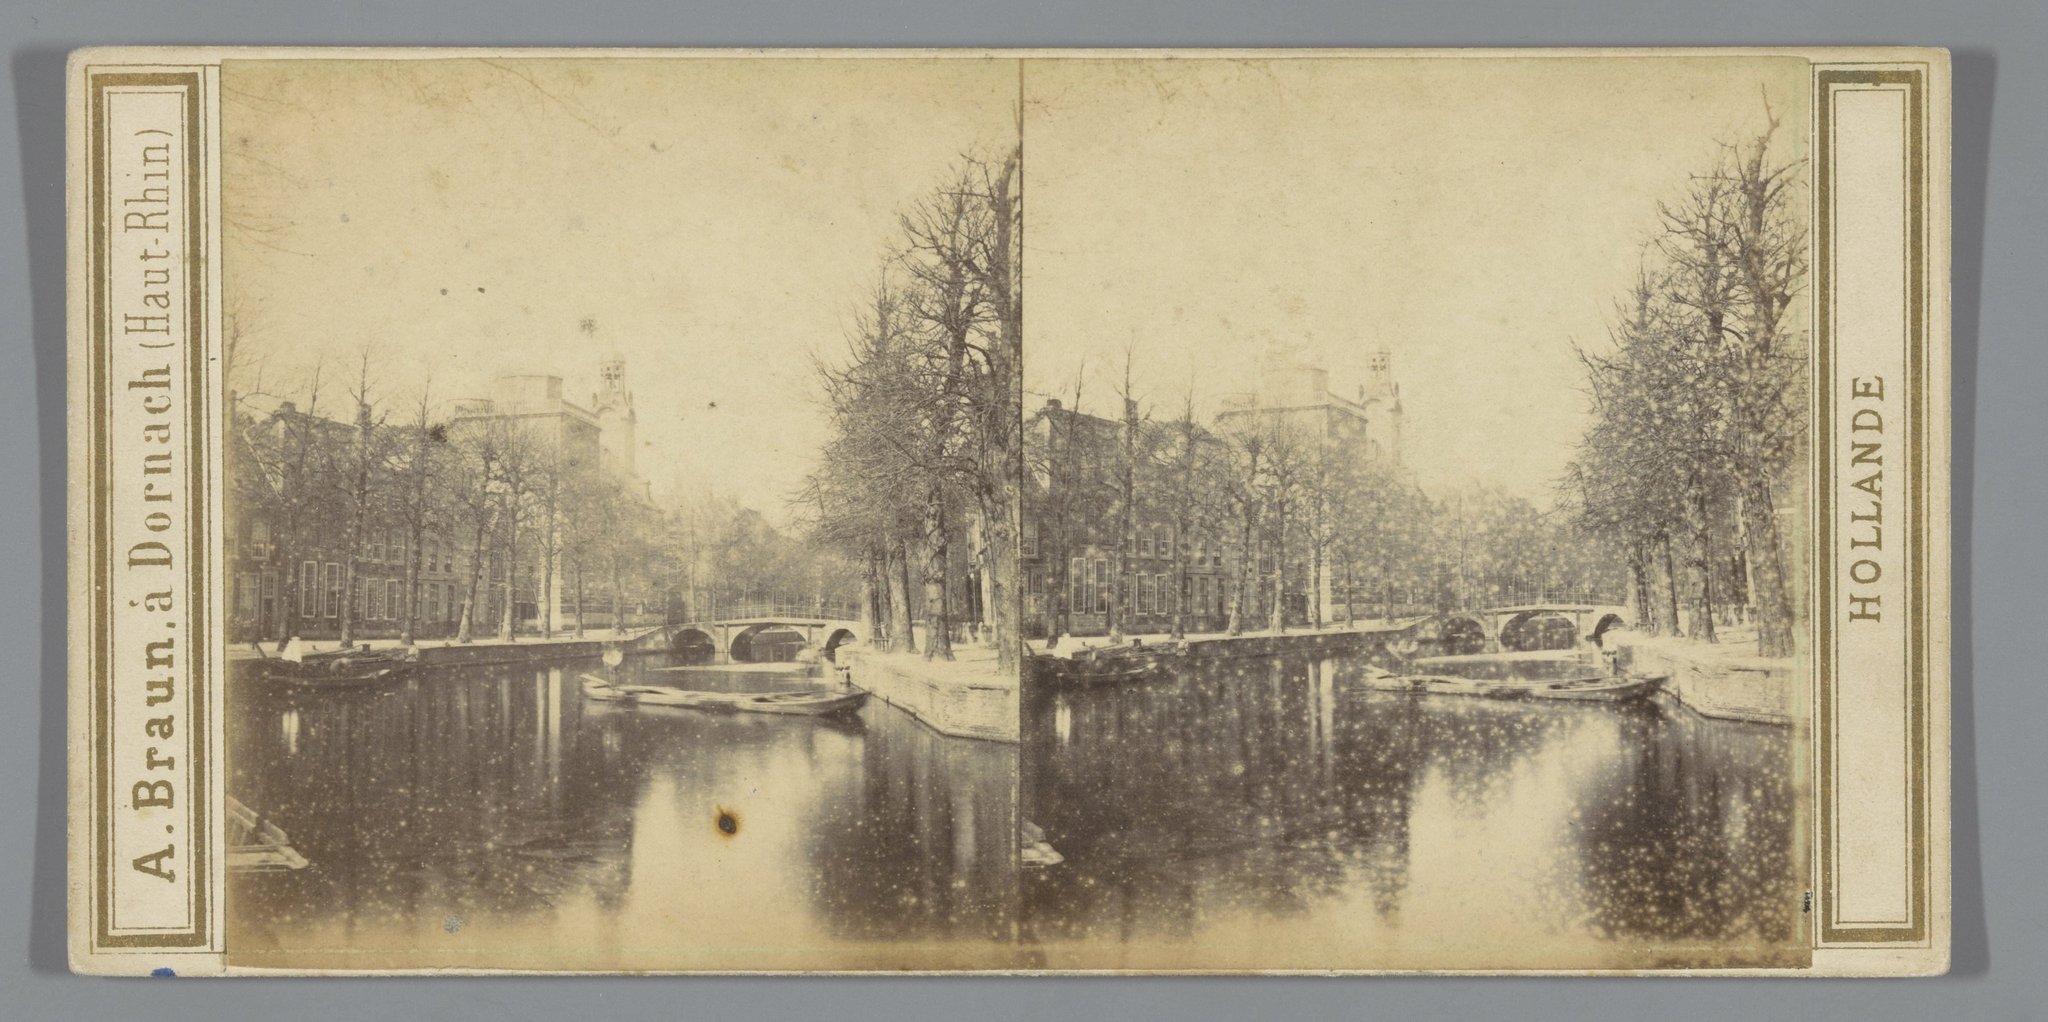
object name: stereograph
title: Leiden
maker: gaston braun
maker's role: fotograaf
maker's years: 1845-1928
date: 1864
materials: cardboard, paper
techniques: albumen print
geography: dornach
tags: canals, waters (in city)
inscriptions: number: ‘No 3870.’, inscription: ‘Nederland’